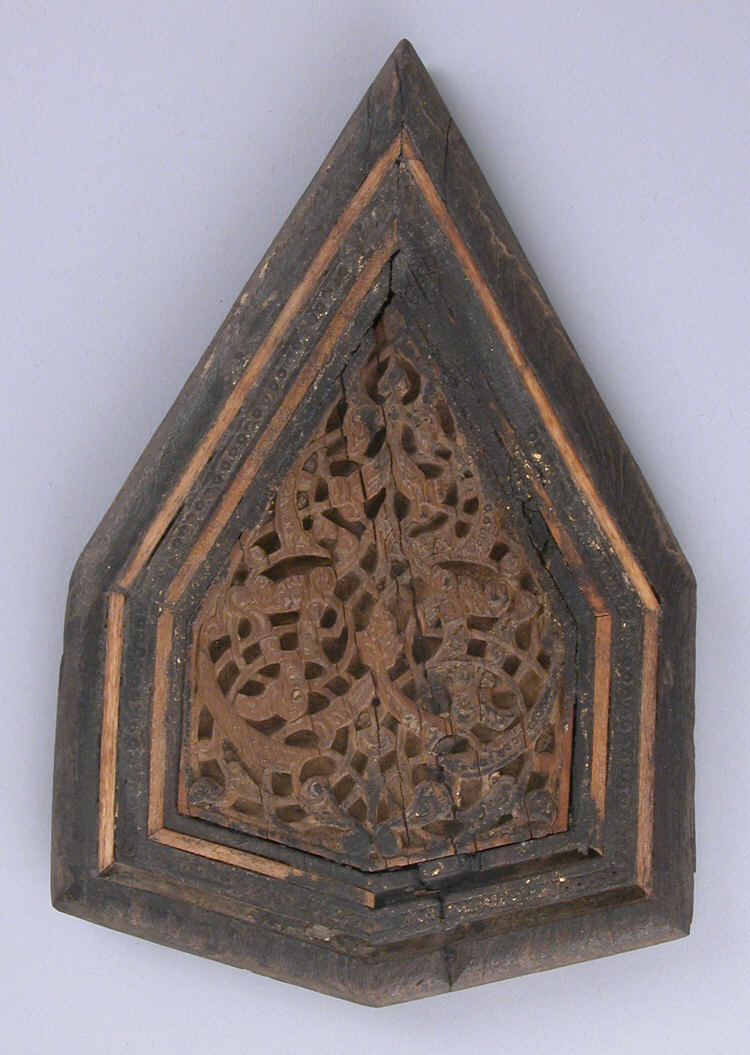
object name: panel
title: Panel from a Minbar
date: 1201-1400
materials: ivory, paint, wood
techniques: carving, inlay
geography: egypt